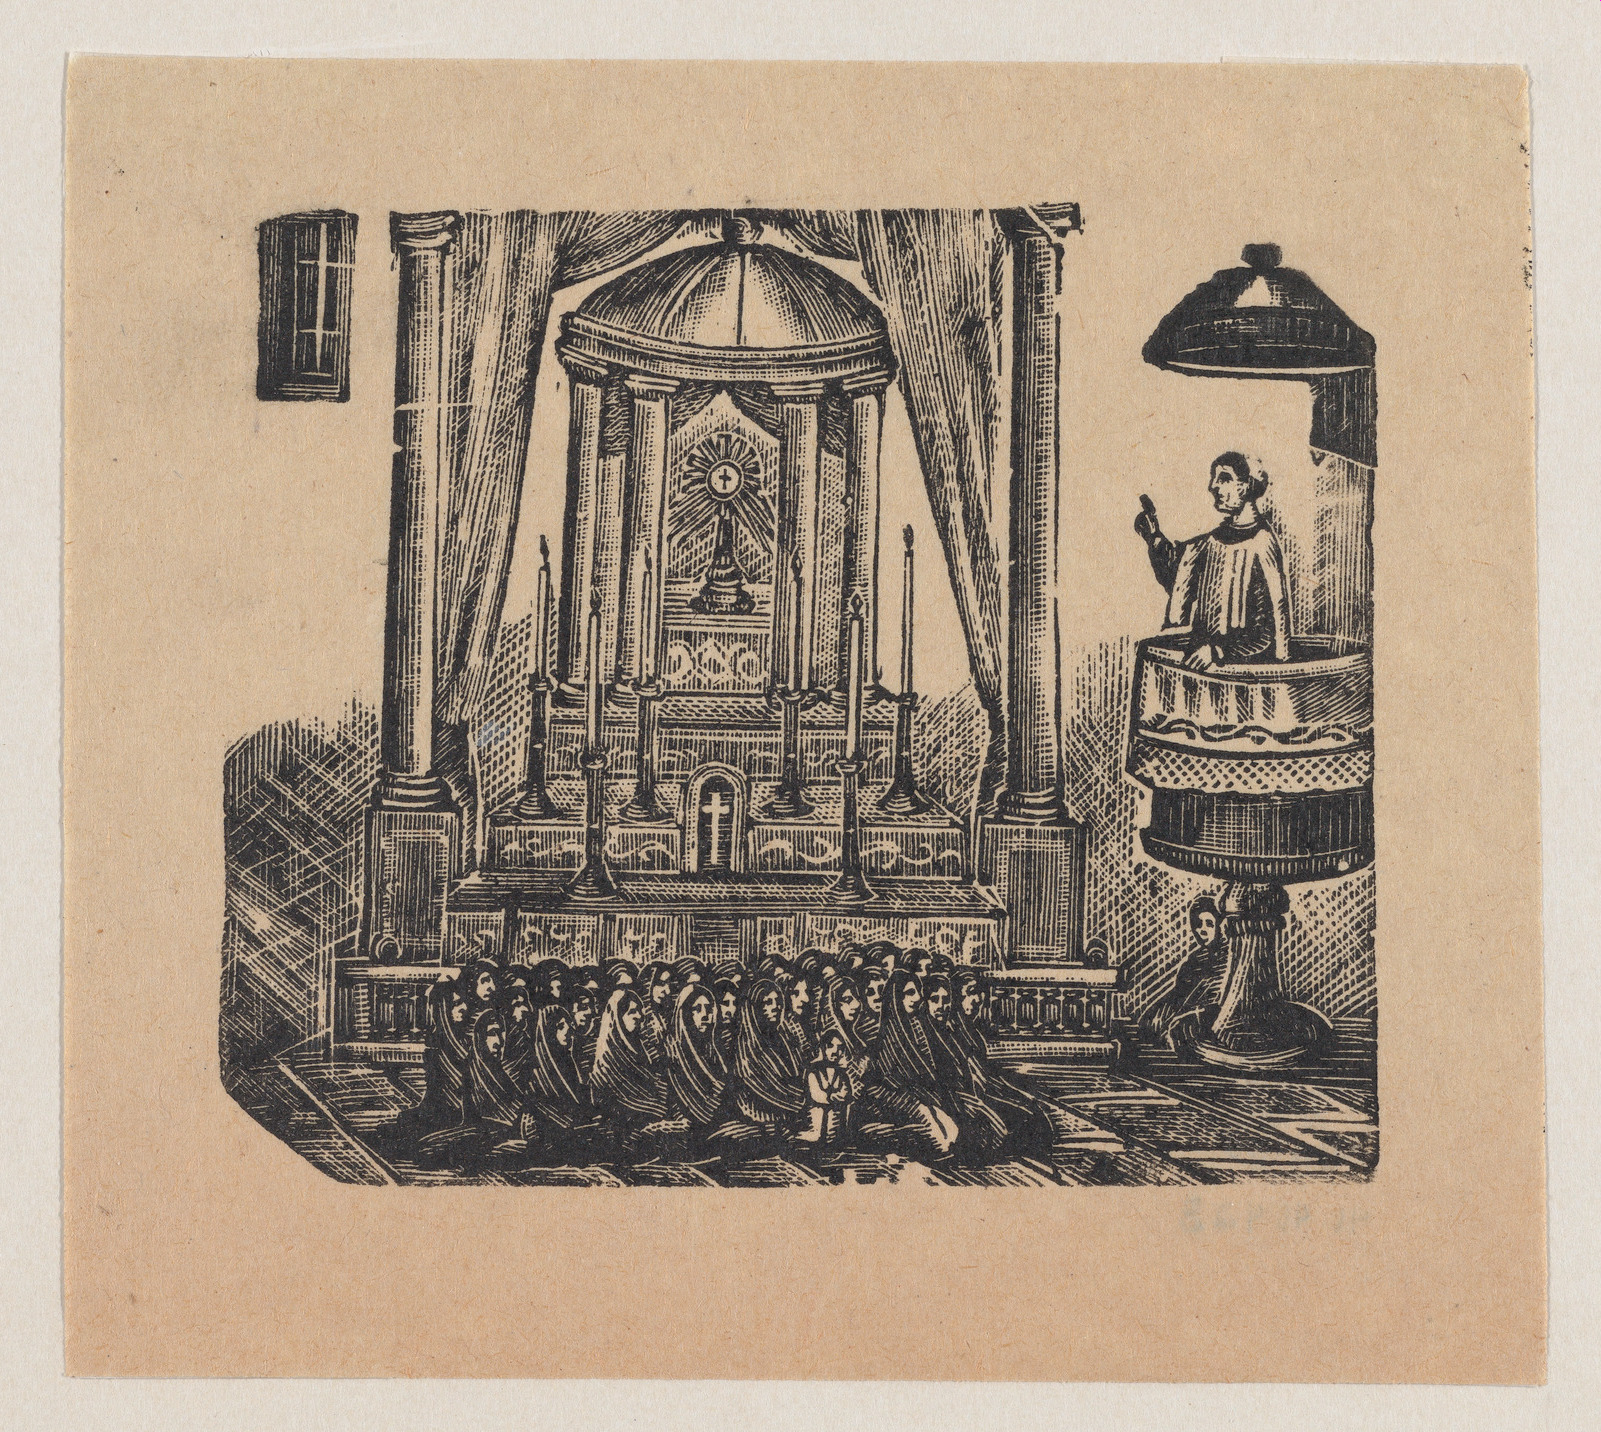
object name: print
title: A priest conducting mass from a pulpit for women dressed in black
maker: josé guadalupe posada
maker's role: artist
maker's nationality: mexican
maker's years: 1852-1913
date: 1890-1910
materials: metal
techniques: engraving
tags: interiors,churches,men,women